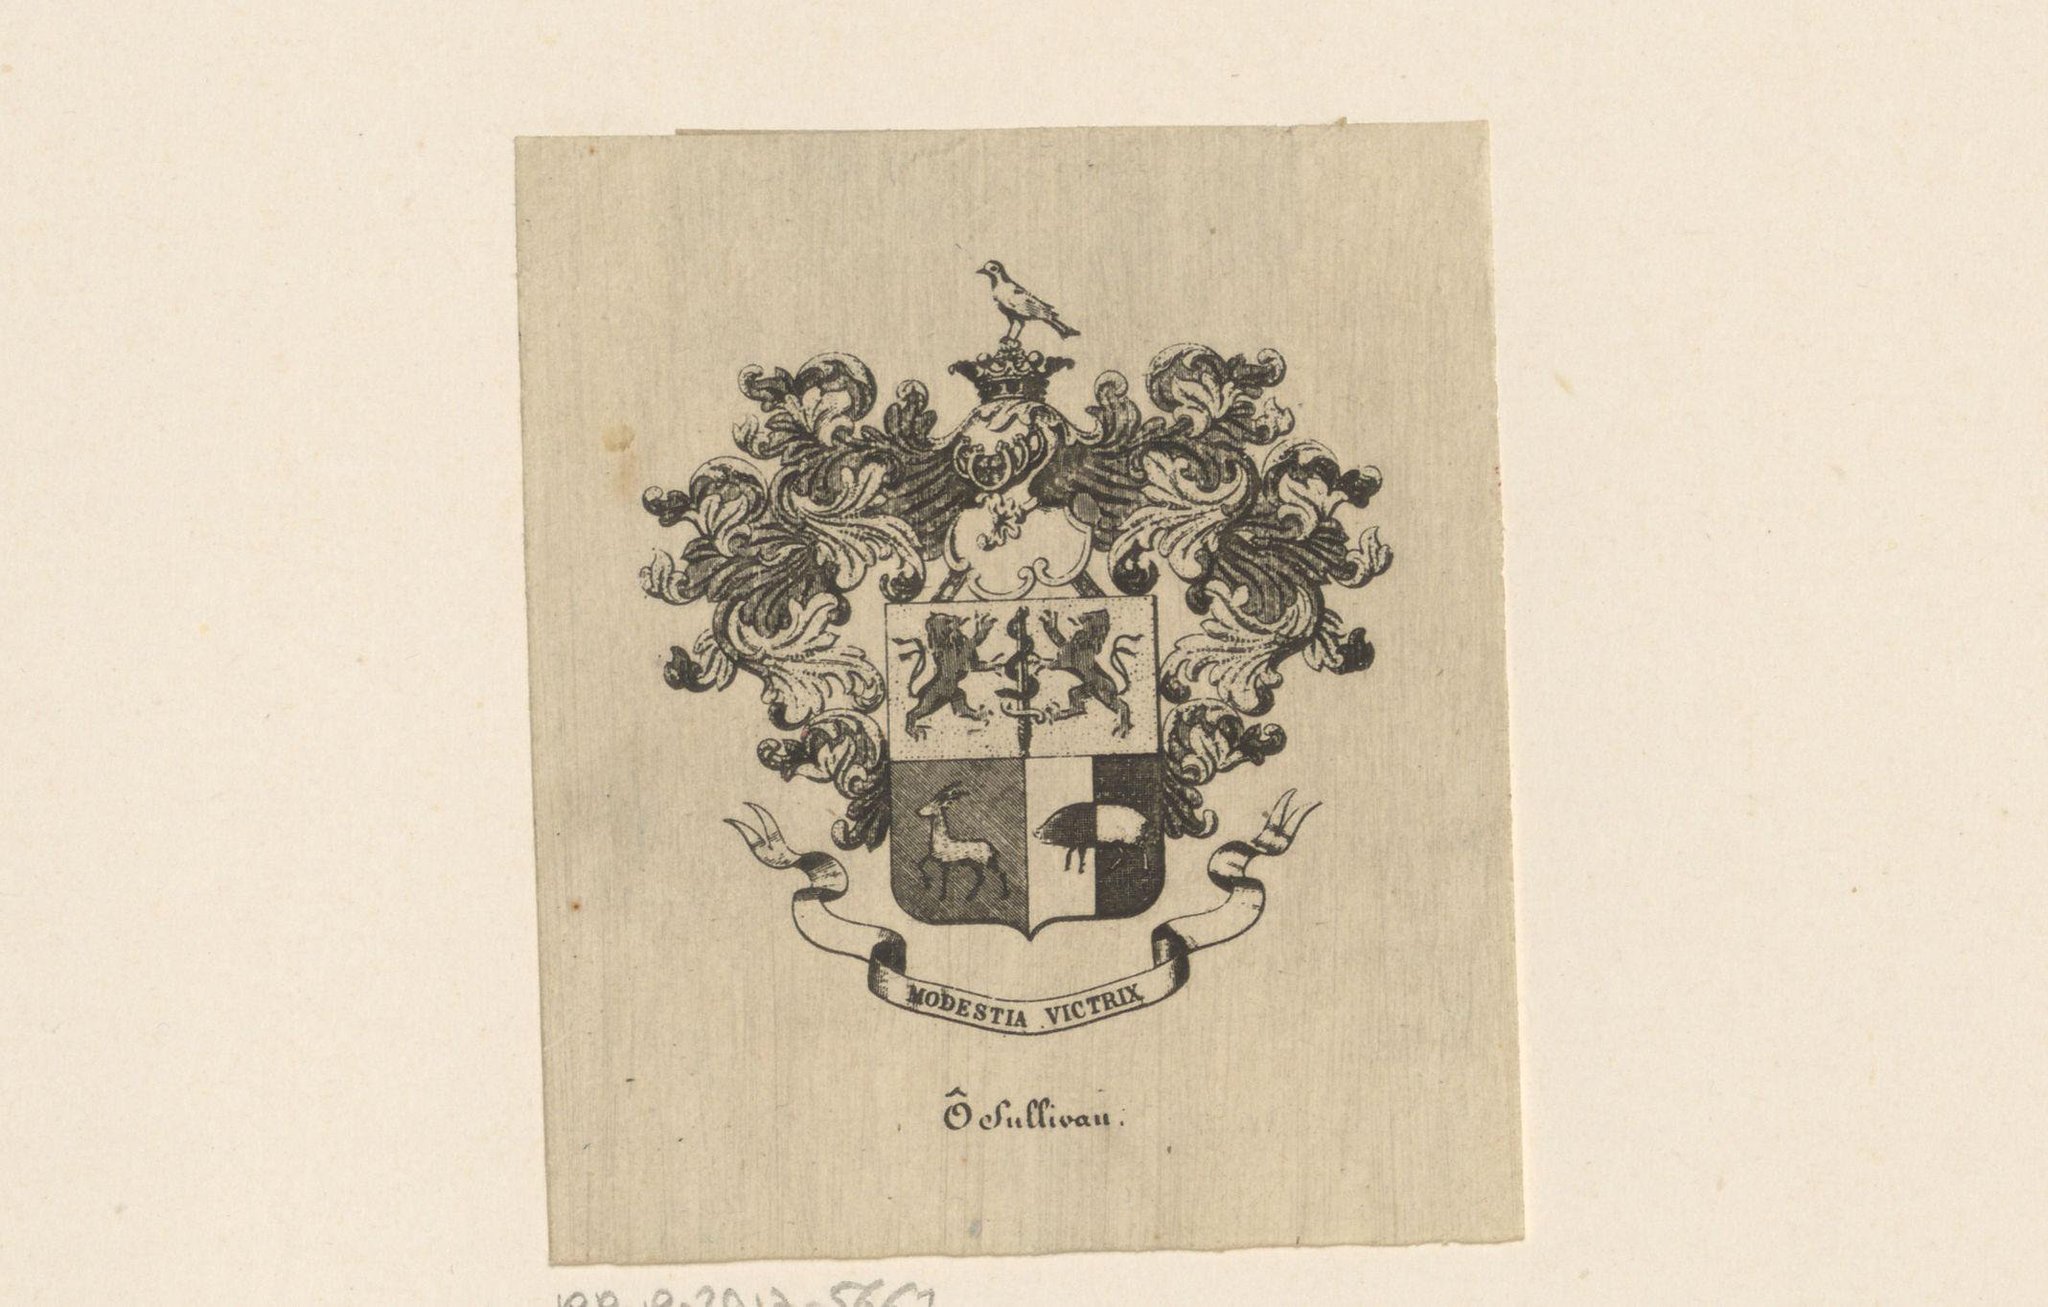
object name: bookplate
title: Ex libris van Ô Sullivan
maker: Anonymous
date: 1850-1924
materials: paper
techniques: etching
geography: england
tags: armorial bearing, heraldry